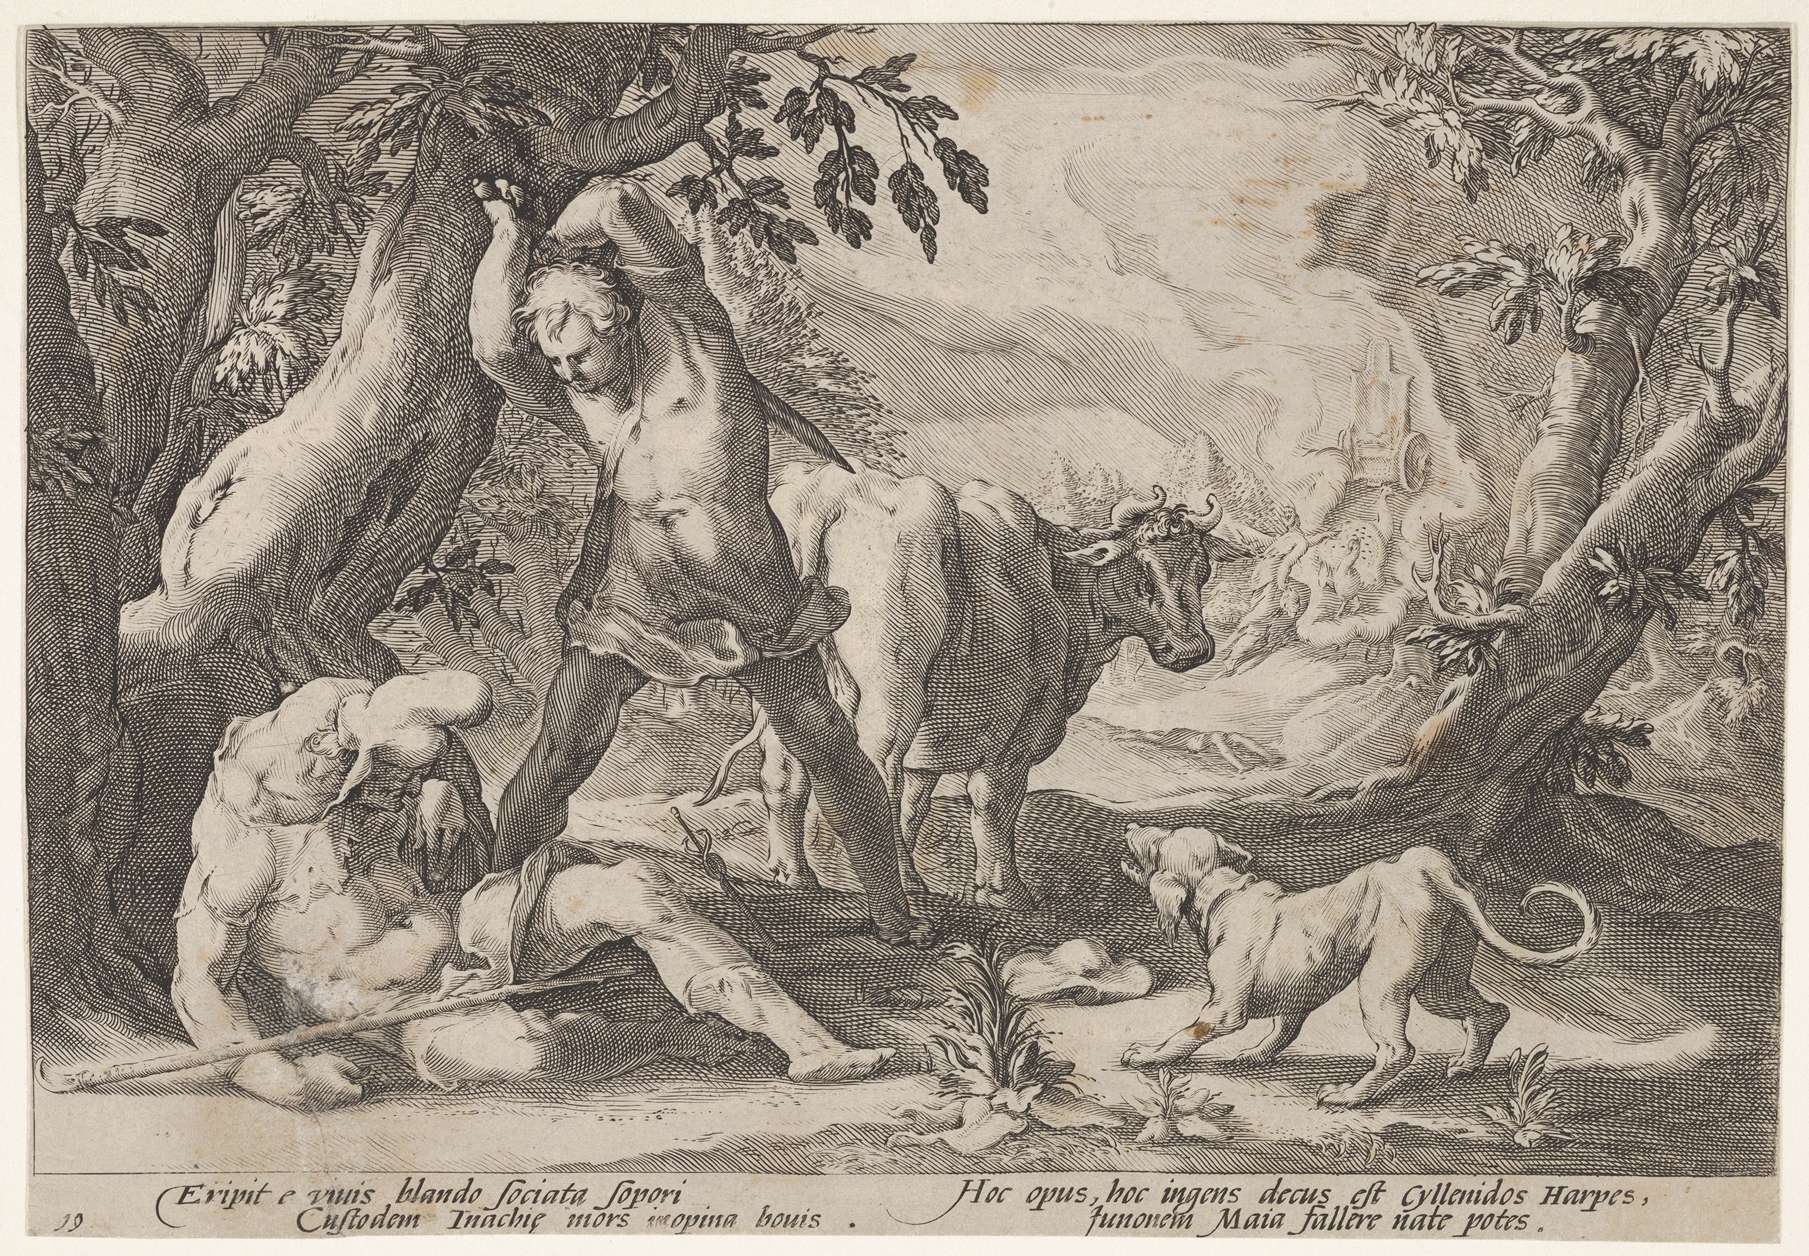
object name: print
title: Mercury and Argus, Io and Juno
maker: robert willemsz de baudous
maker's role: artist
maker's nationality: netherlandish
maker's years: 1574-1659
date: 1565-1750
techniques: engraving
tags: juno,mercury,bulls,dogs